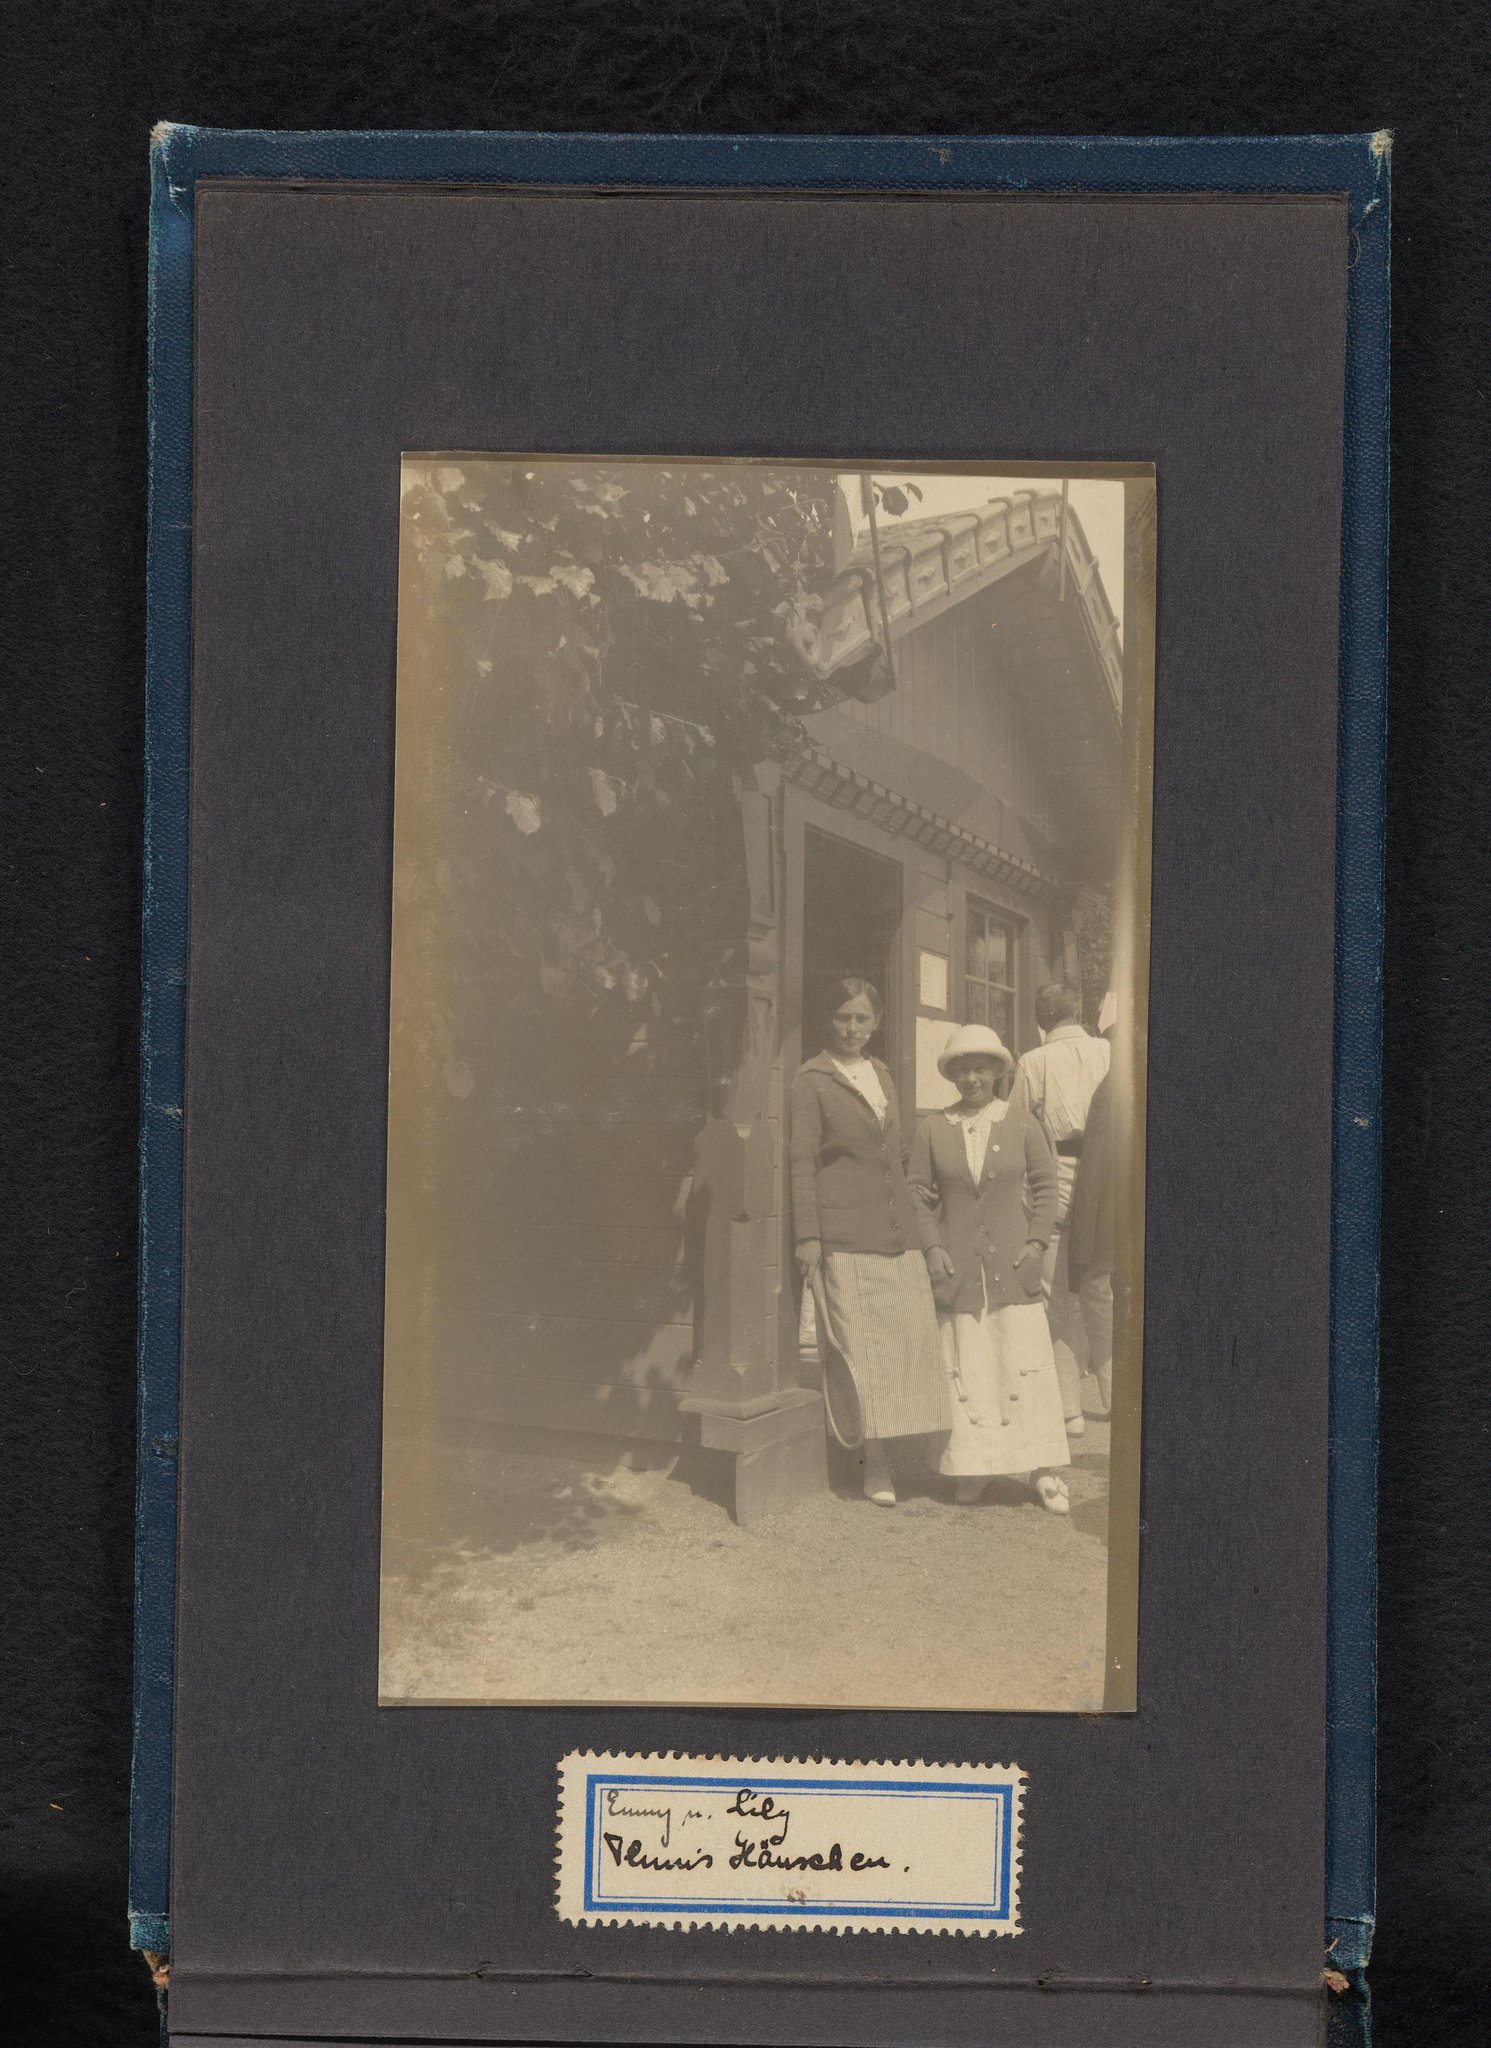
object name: album leaf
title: Drie vrouwen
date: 1913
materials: paper, photographic support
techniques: gelatin silver print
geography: germany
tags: else wachenheimer-moos, historical persons - bb - woman, germany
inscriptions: inscription: ‘Die 2 Holms, Wally Weiner / Im Garten’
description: Albumblad met een foto van drie vrouwen op stoelen in de tuin. Onderdeel van het fotoalbum van Else Wachenheimer-Moos en haar broers Arthur en Willy Moos en anderen in de periode 1913-1918.